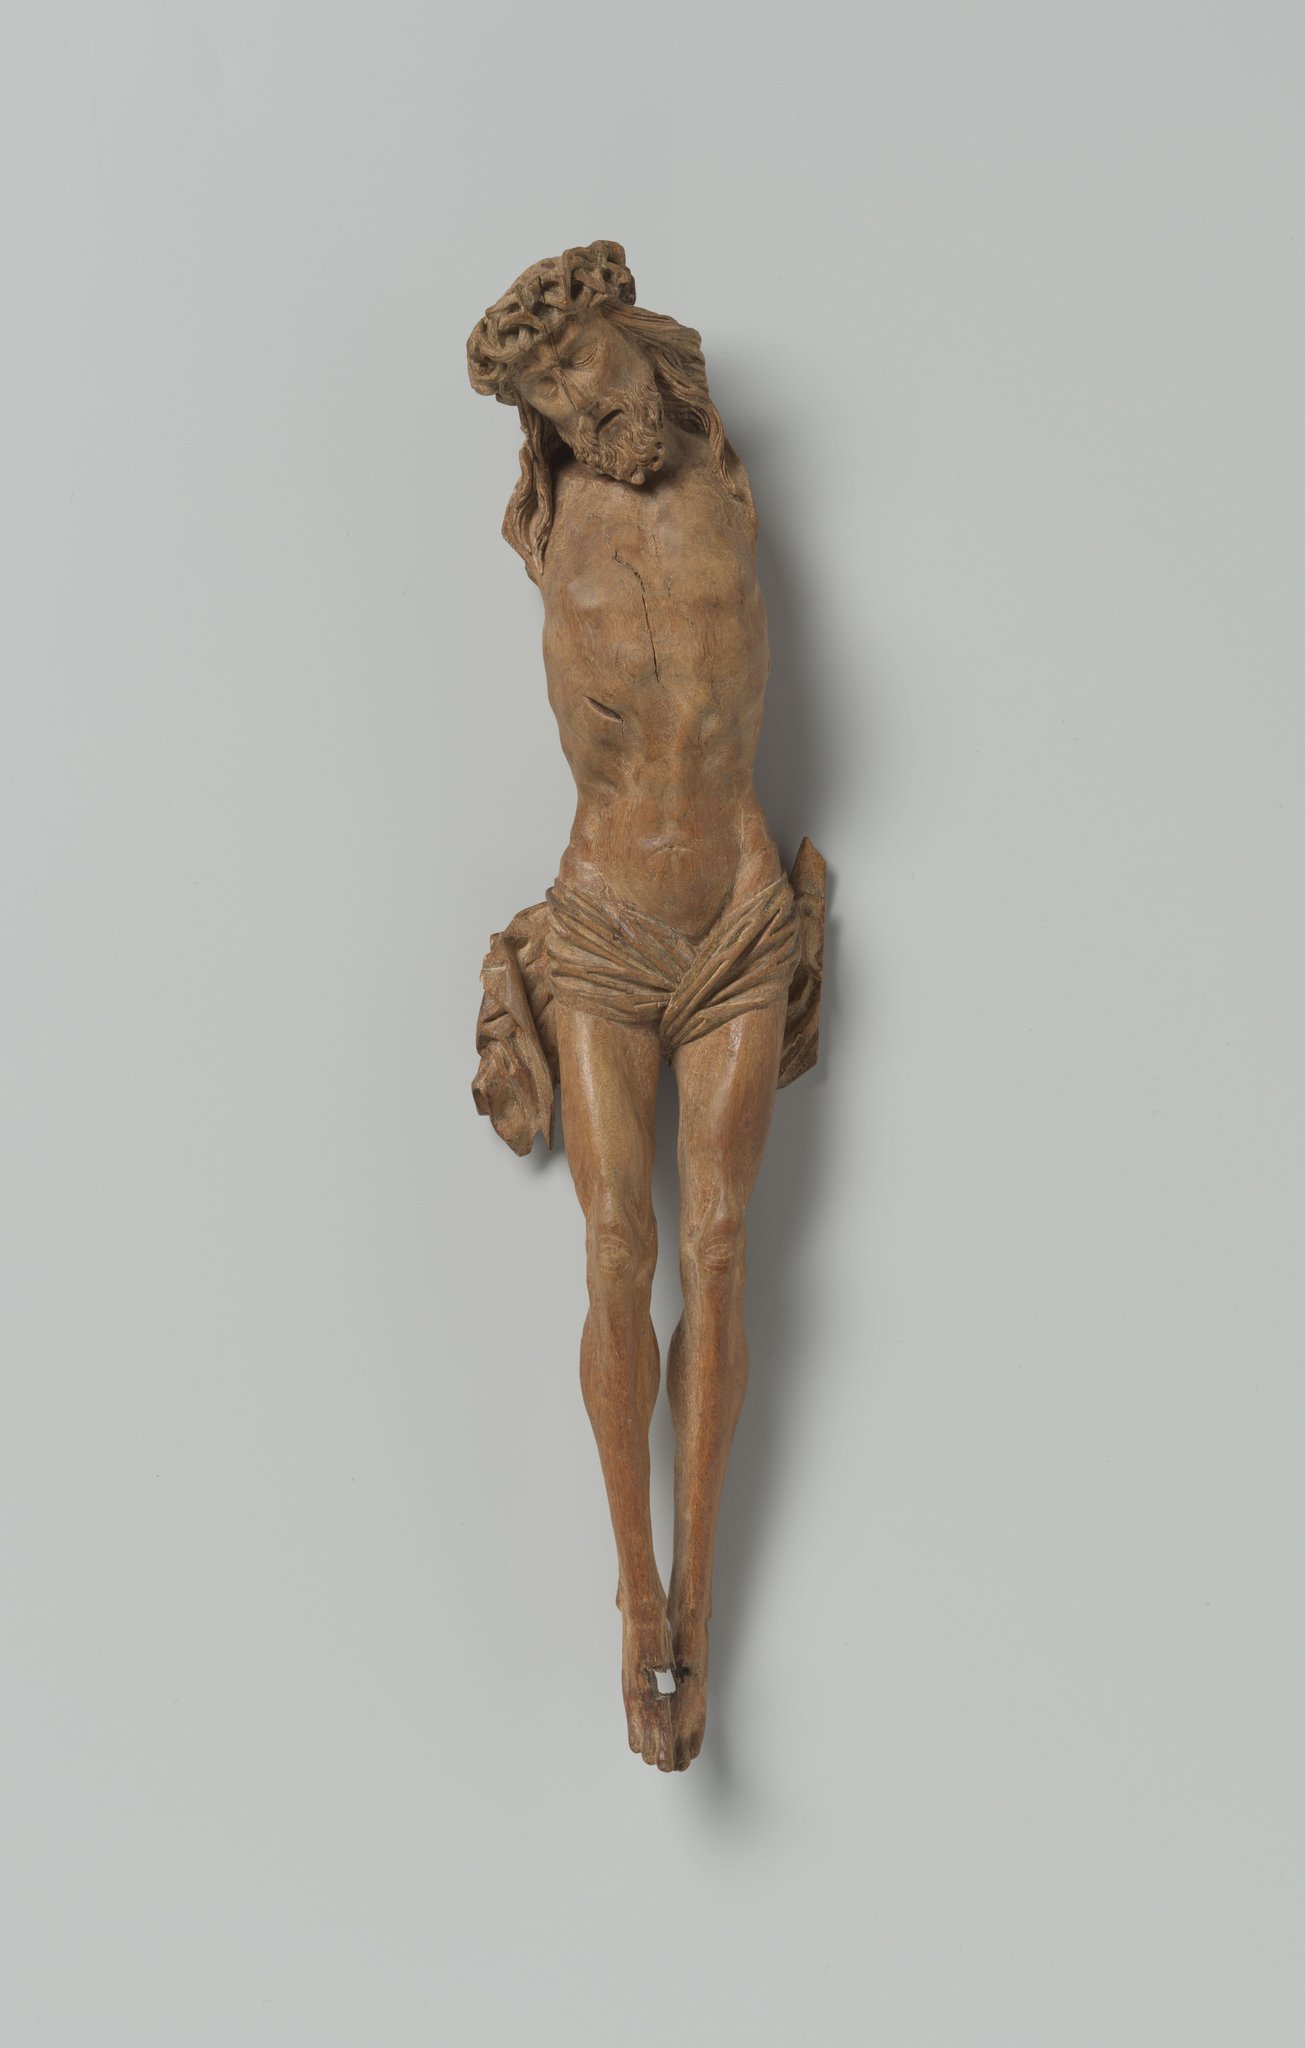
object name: figure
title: Gekruisigde Christus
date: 1490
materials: wood, paint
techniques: cutting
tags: christ on the cross on golgotha (alone, without bystanders)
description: Het uitgeteerde lichaam met ingesnoerde middel heeft een geprononceerde ribbenkast met zijdewond en een licht gewelfde buik. De dunne lendendoek is min of meer symmetrisch in fijne plooien tussen Christus' benen getrokken en waaiert aan beide zijden uit. De lange slanke benen zijn tanig en tonen gespannen pezen en spieren. Het hoofd van Christus hangt neer en heeft een geopende mond en gesloten ogen: Christus is gestorven weergegeven.